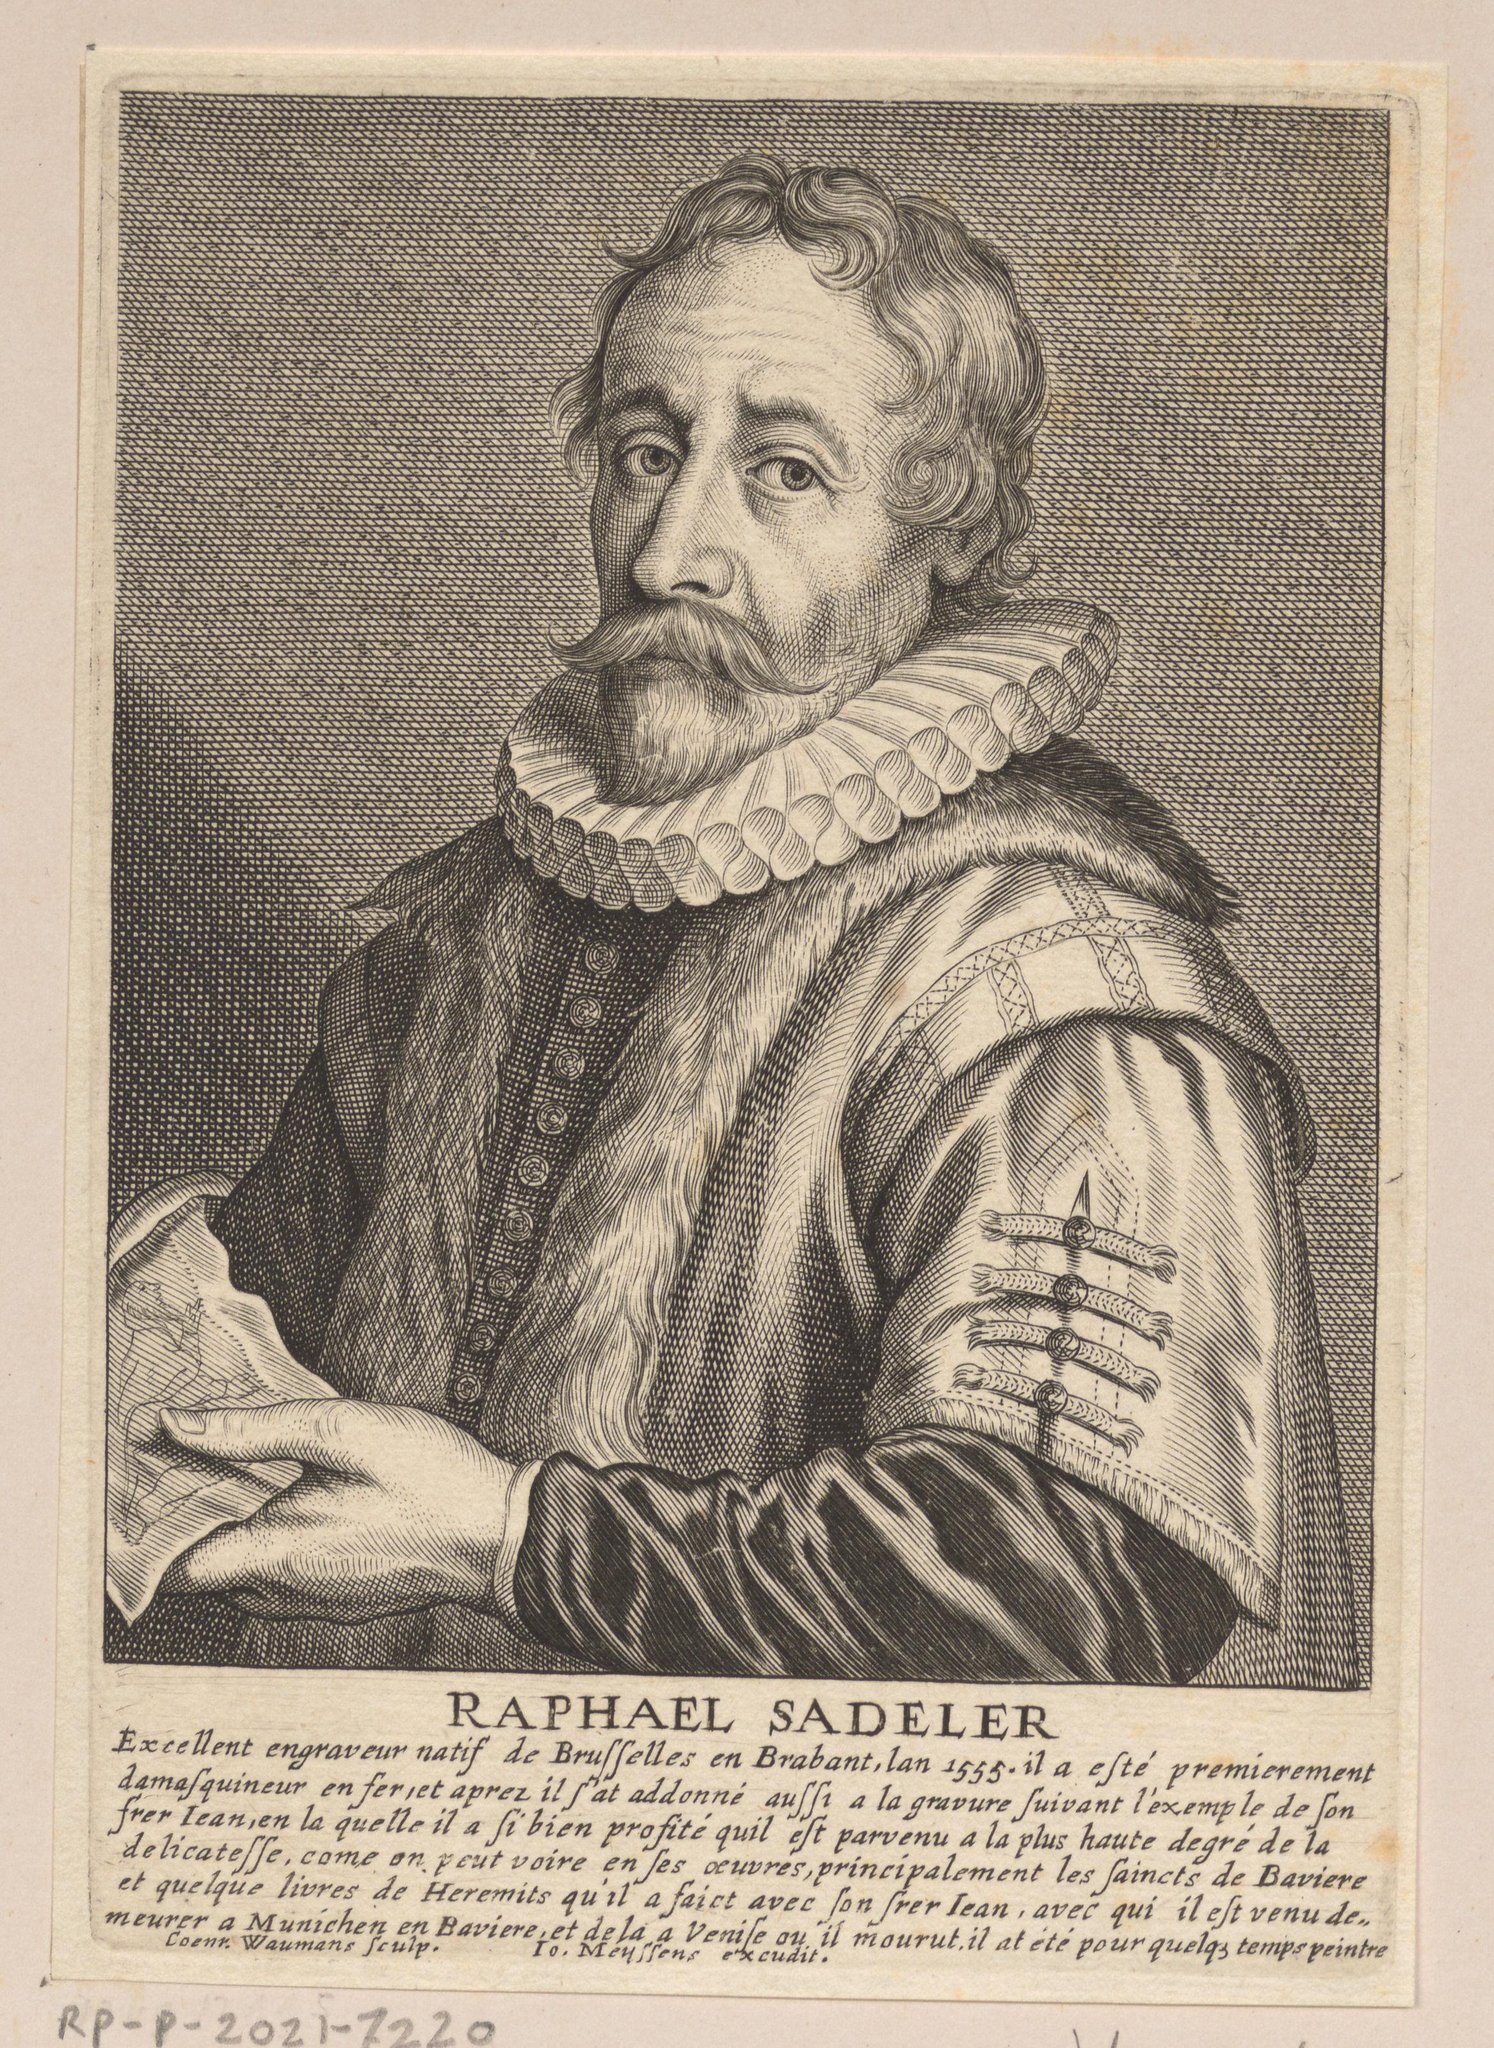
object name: print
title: Portret van Raphaël Sadeler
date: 1649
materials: paper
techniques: engraving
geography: antwerp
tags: raphaël sadeler, historical persons, portrait, self-portrait of graphic artist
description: Prent mogelijk uit: Image de divers hommes d'esprit sublime, qui par leur art et science devraient vivre éternellement et desquels la louange et renommée faict estonner le monde. Antwerpen: Joannes Meyssens, 1649. Prent met tekst op verso gebruikt in: Bie, Cornelis de. Het gulden cabinet vande edel vry schilder const (...). Antwerpen: Joannes Meyssens, 1662 [1661 foutief op titelpagina].